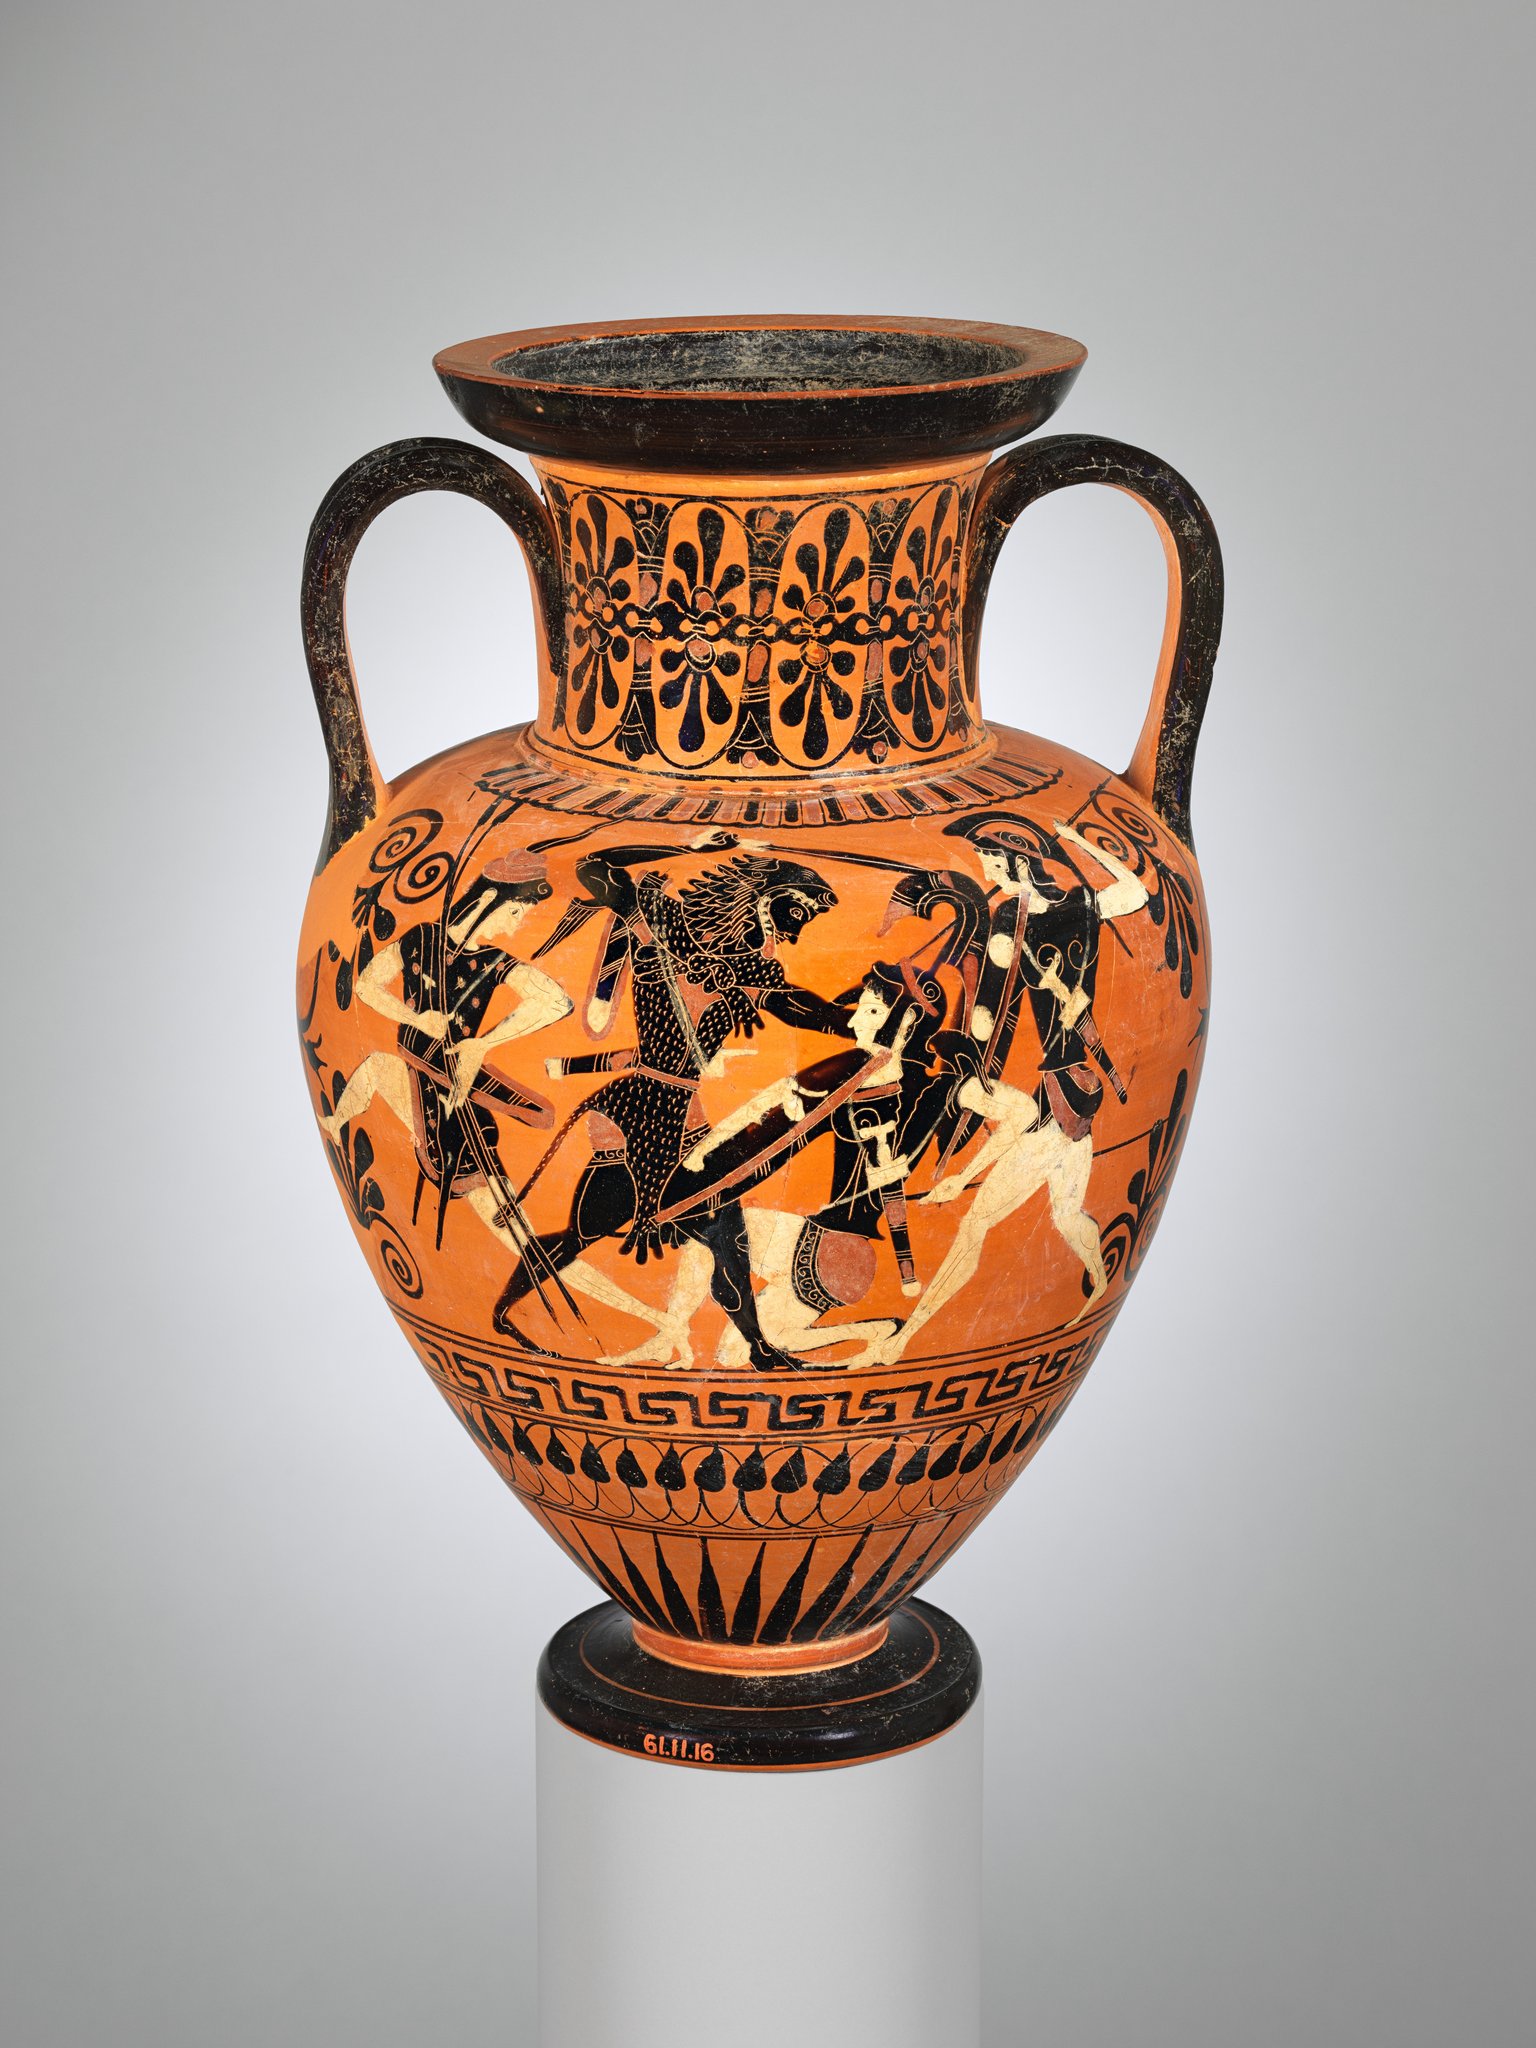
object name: neck amphora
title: Terracotta neck-amphora (jar)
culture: greek, attic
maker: medea group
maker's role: artist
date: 520 BCE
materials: terracotta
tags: spears,women,amazons,herakles